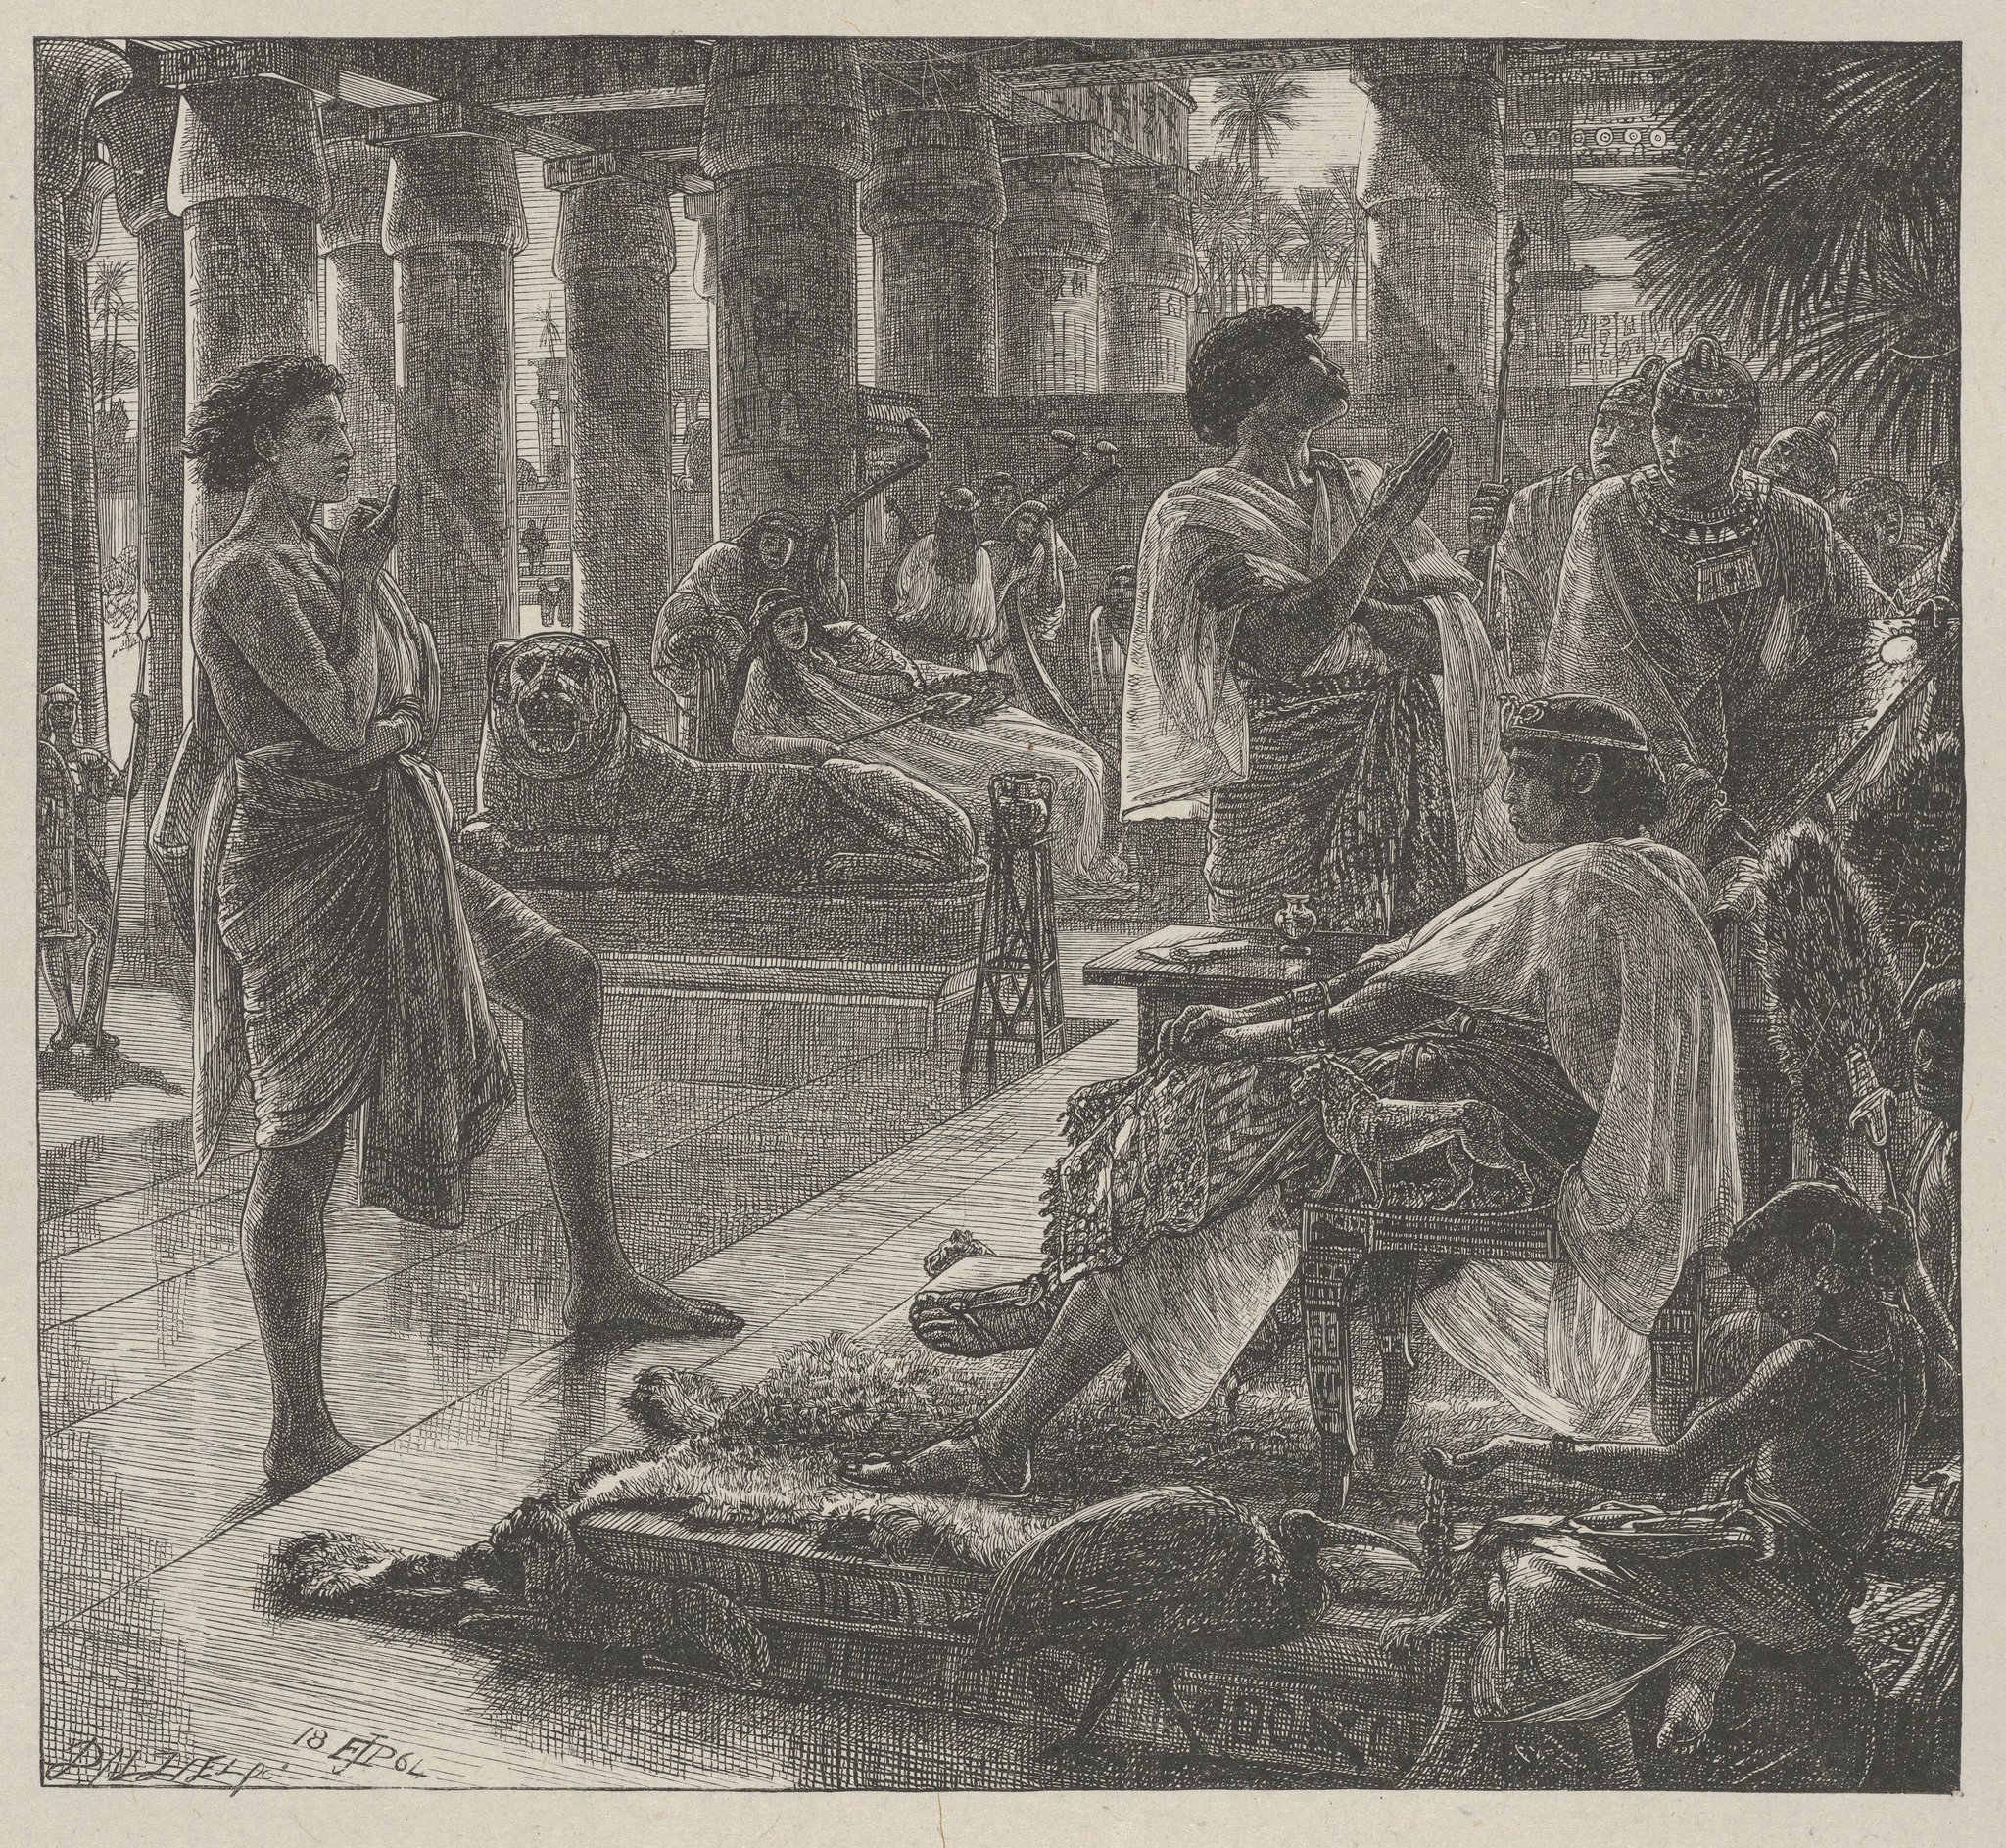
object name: print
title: Joseph Before Pharoah, from "Dalziels' Bible Gallery"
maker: sir edward john poynter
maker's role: artist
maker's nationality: british, born france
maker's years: 1836-1919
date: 1864-1881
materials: paper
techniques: engraving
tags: birds,kings,men,women,lions